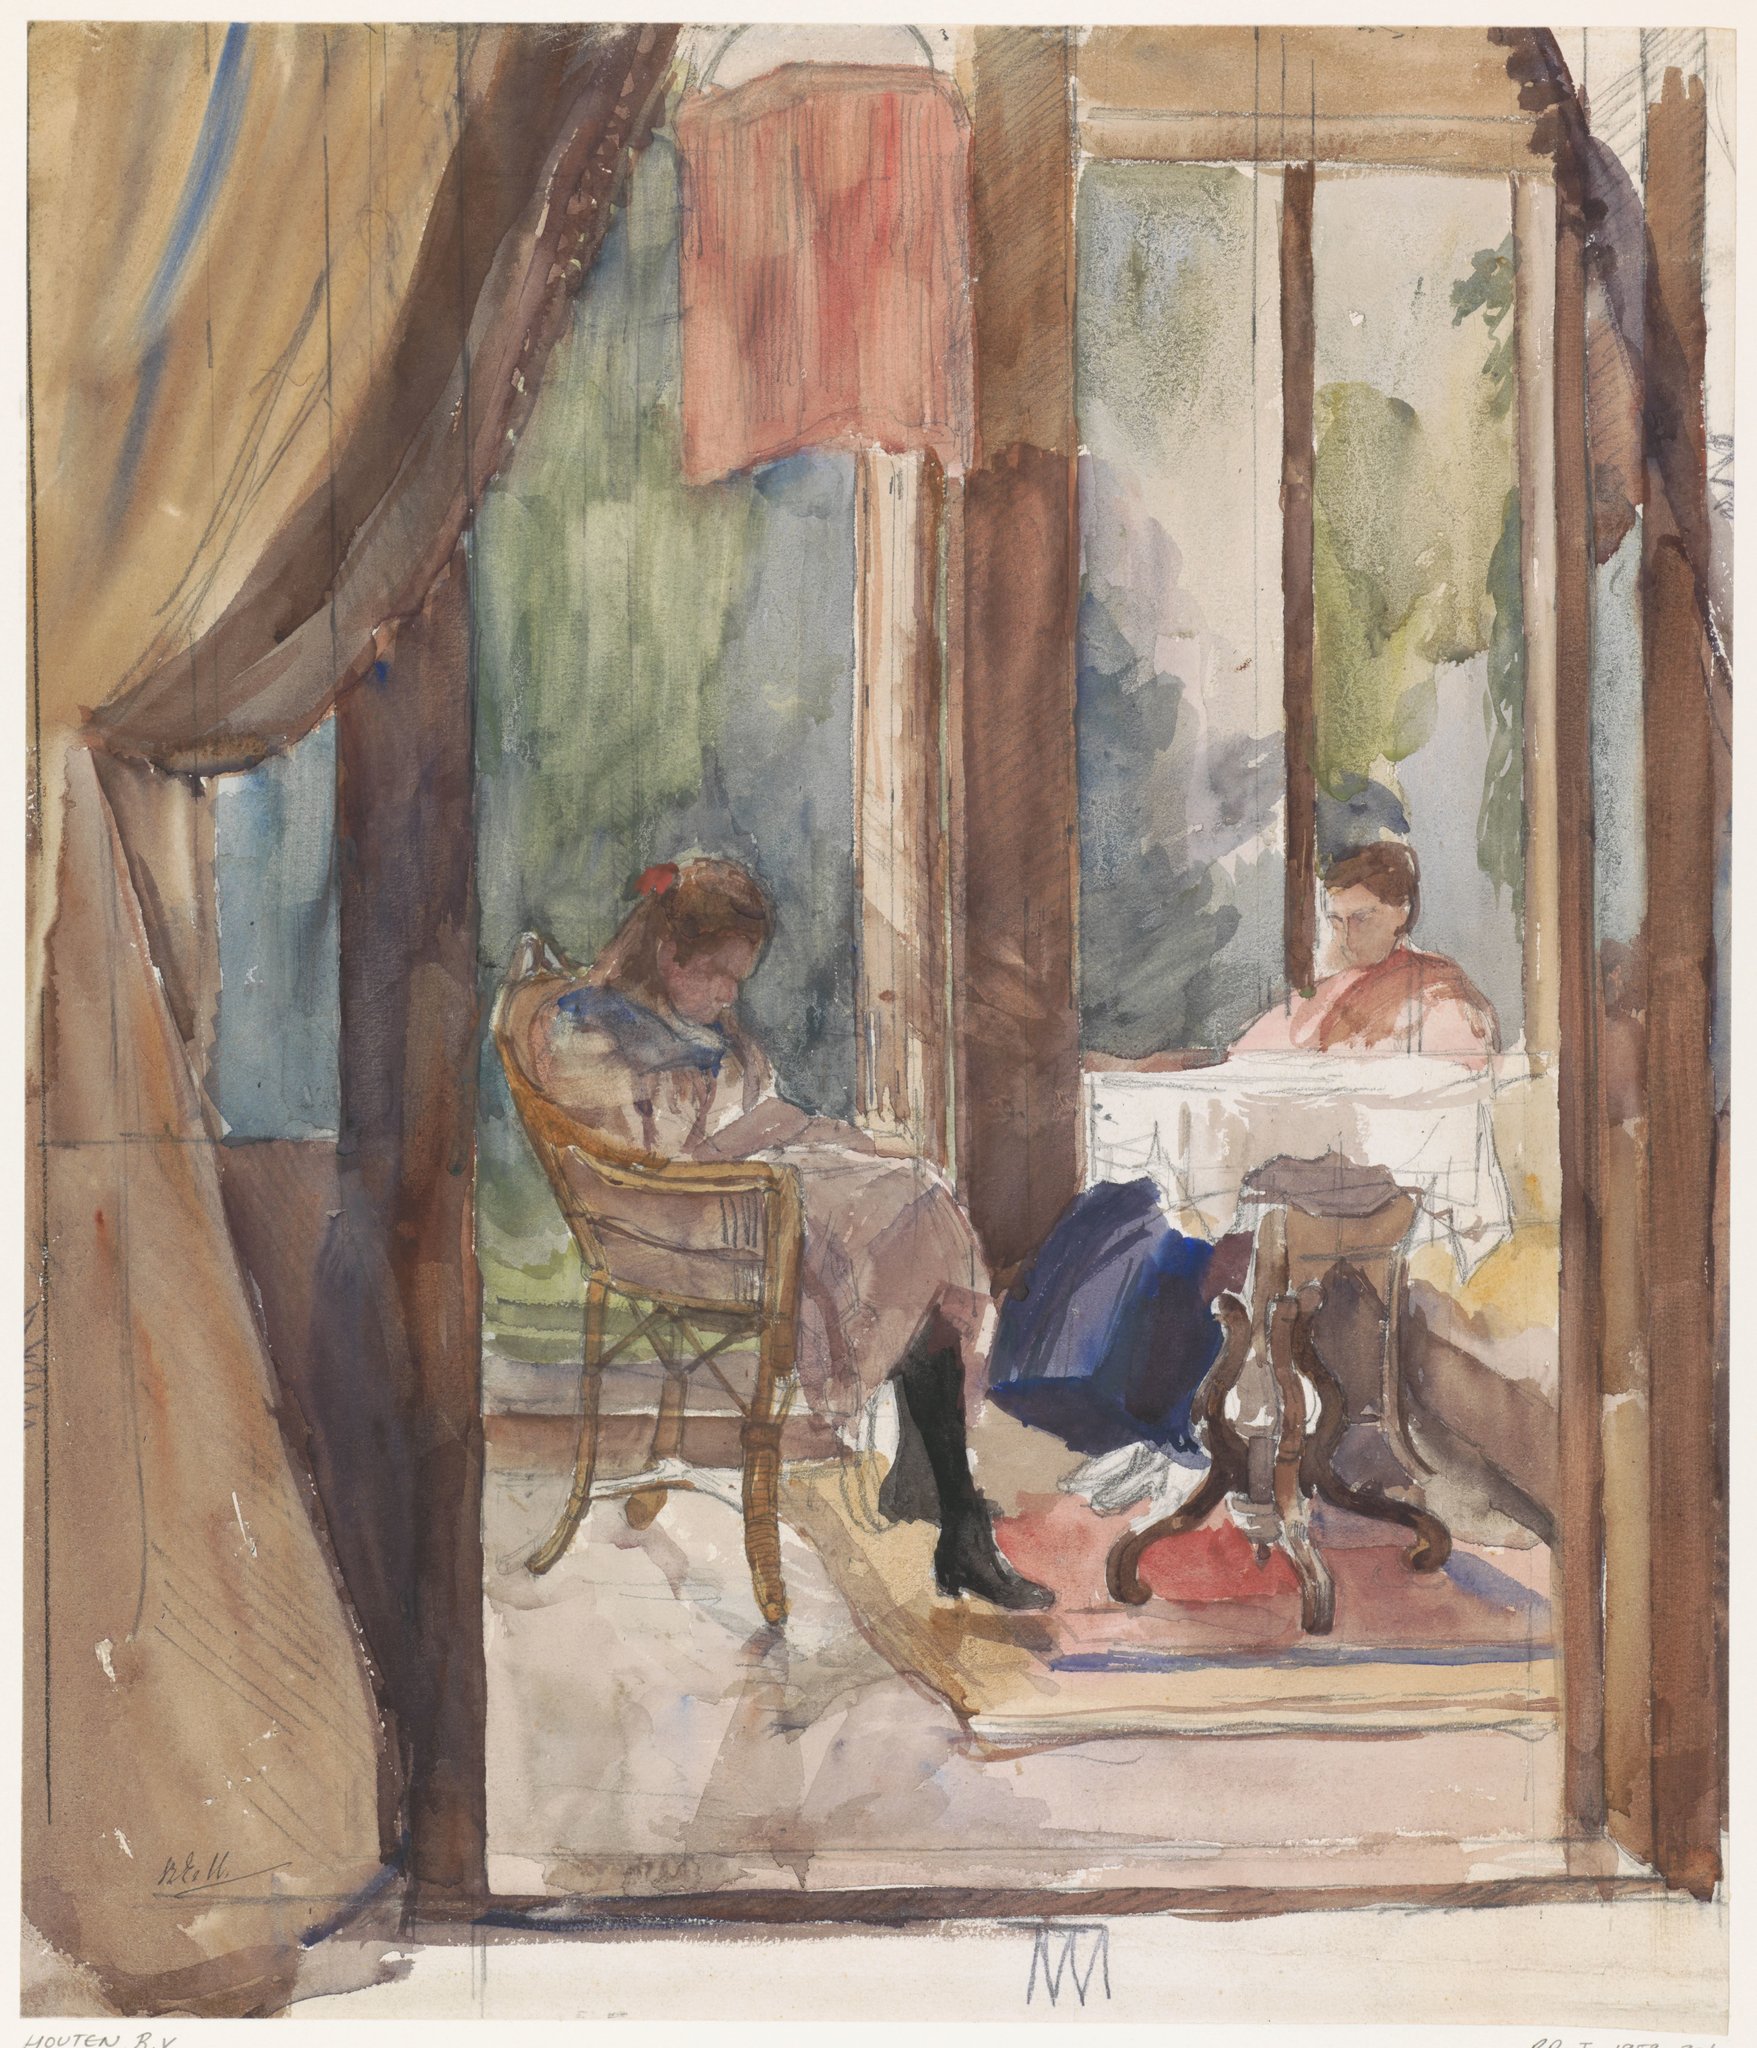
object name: drawing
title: Dame en een jong meisje, beide lezend in de serre van het huis aan de Riouwstraat 6, te Den Haag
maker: barbara elisabeth van houten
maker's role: draughtsman, print maker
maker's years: 1862-1950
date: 1872-1950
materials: paper, pencil, watercolor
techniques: brush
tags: reading, sun-porch, sun-parlour, glazed verandah, girl (child between toddler and youth), male sex; man, the hague